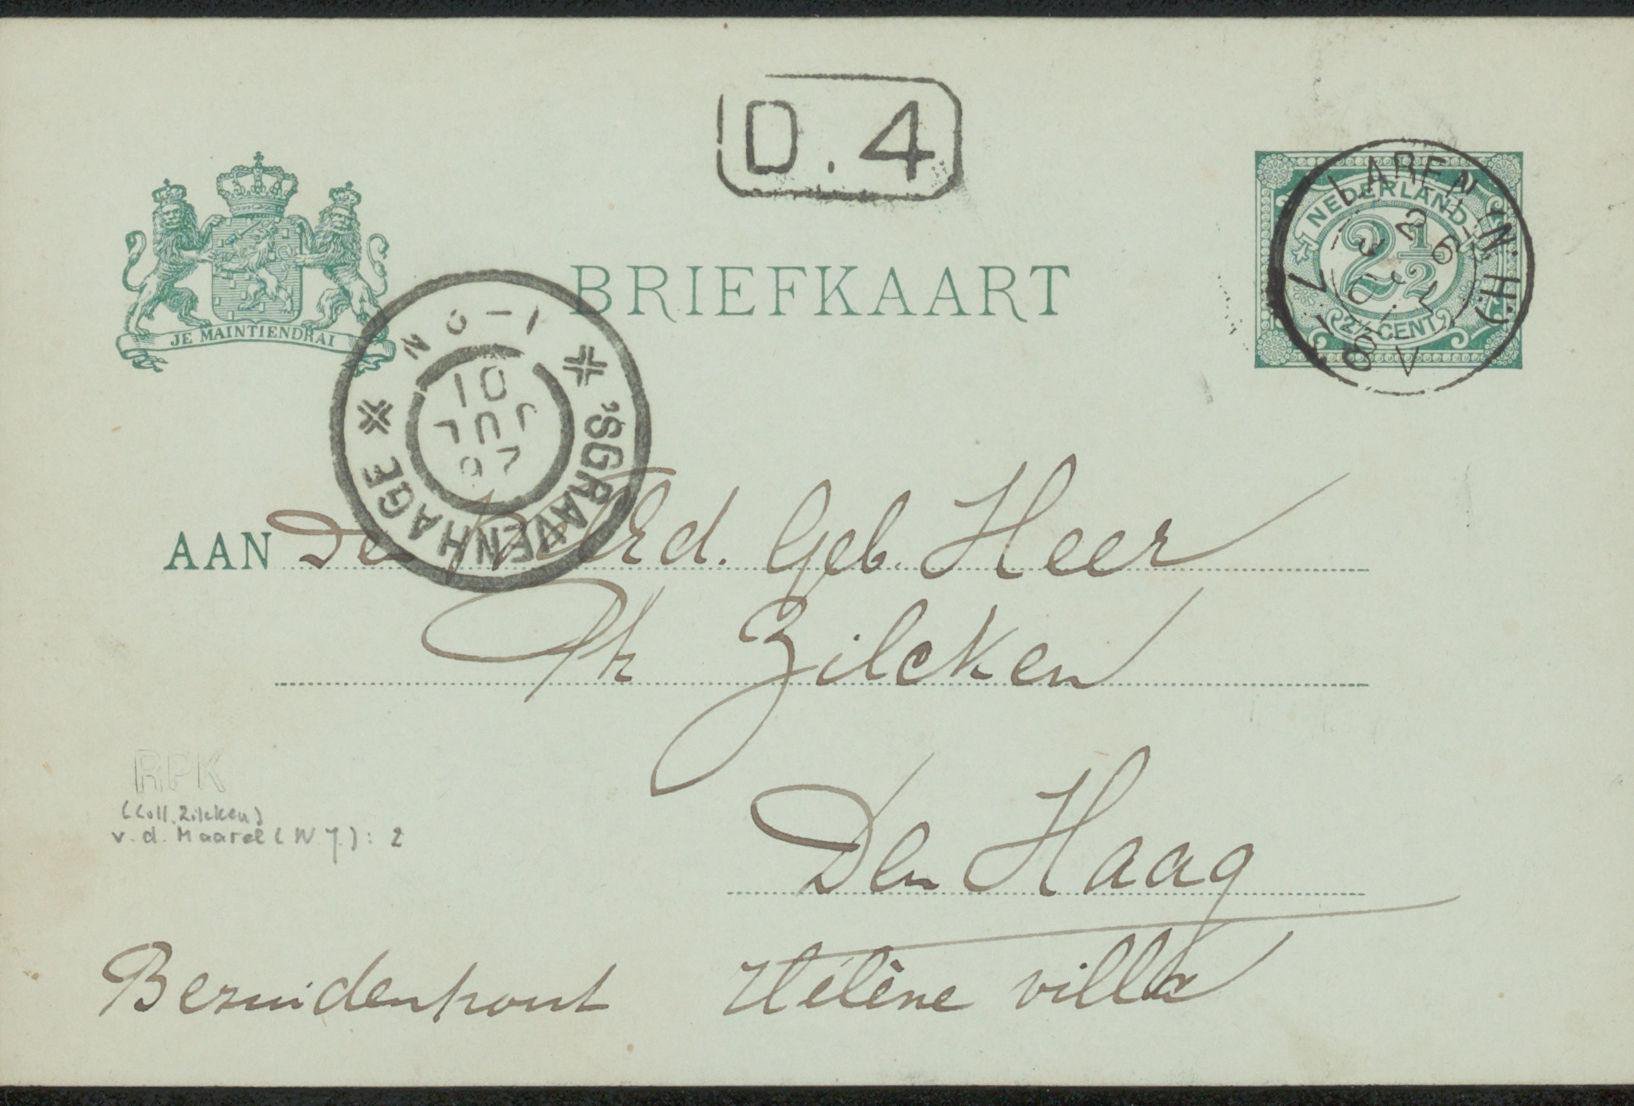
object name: postcard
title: Briefkaart aan Philip Zilcken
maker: wilhelmina j.m. clasener-van der maarel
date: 1901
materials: cardboard, ink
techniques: pen, writing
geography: laren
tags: the hague, painter, draughtsman, philip zilcken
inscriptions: collector's mark: ‘RPK’